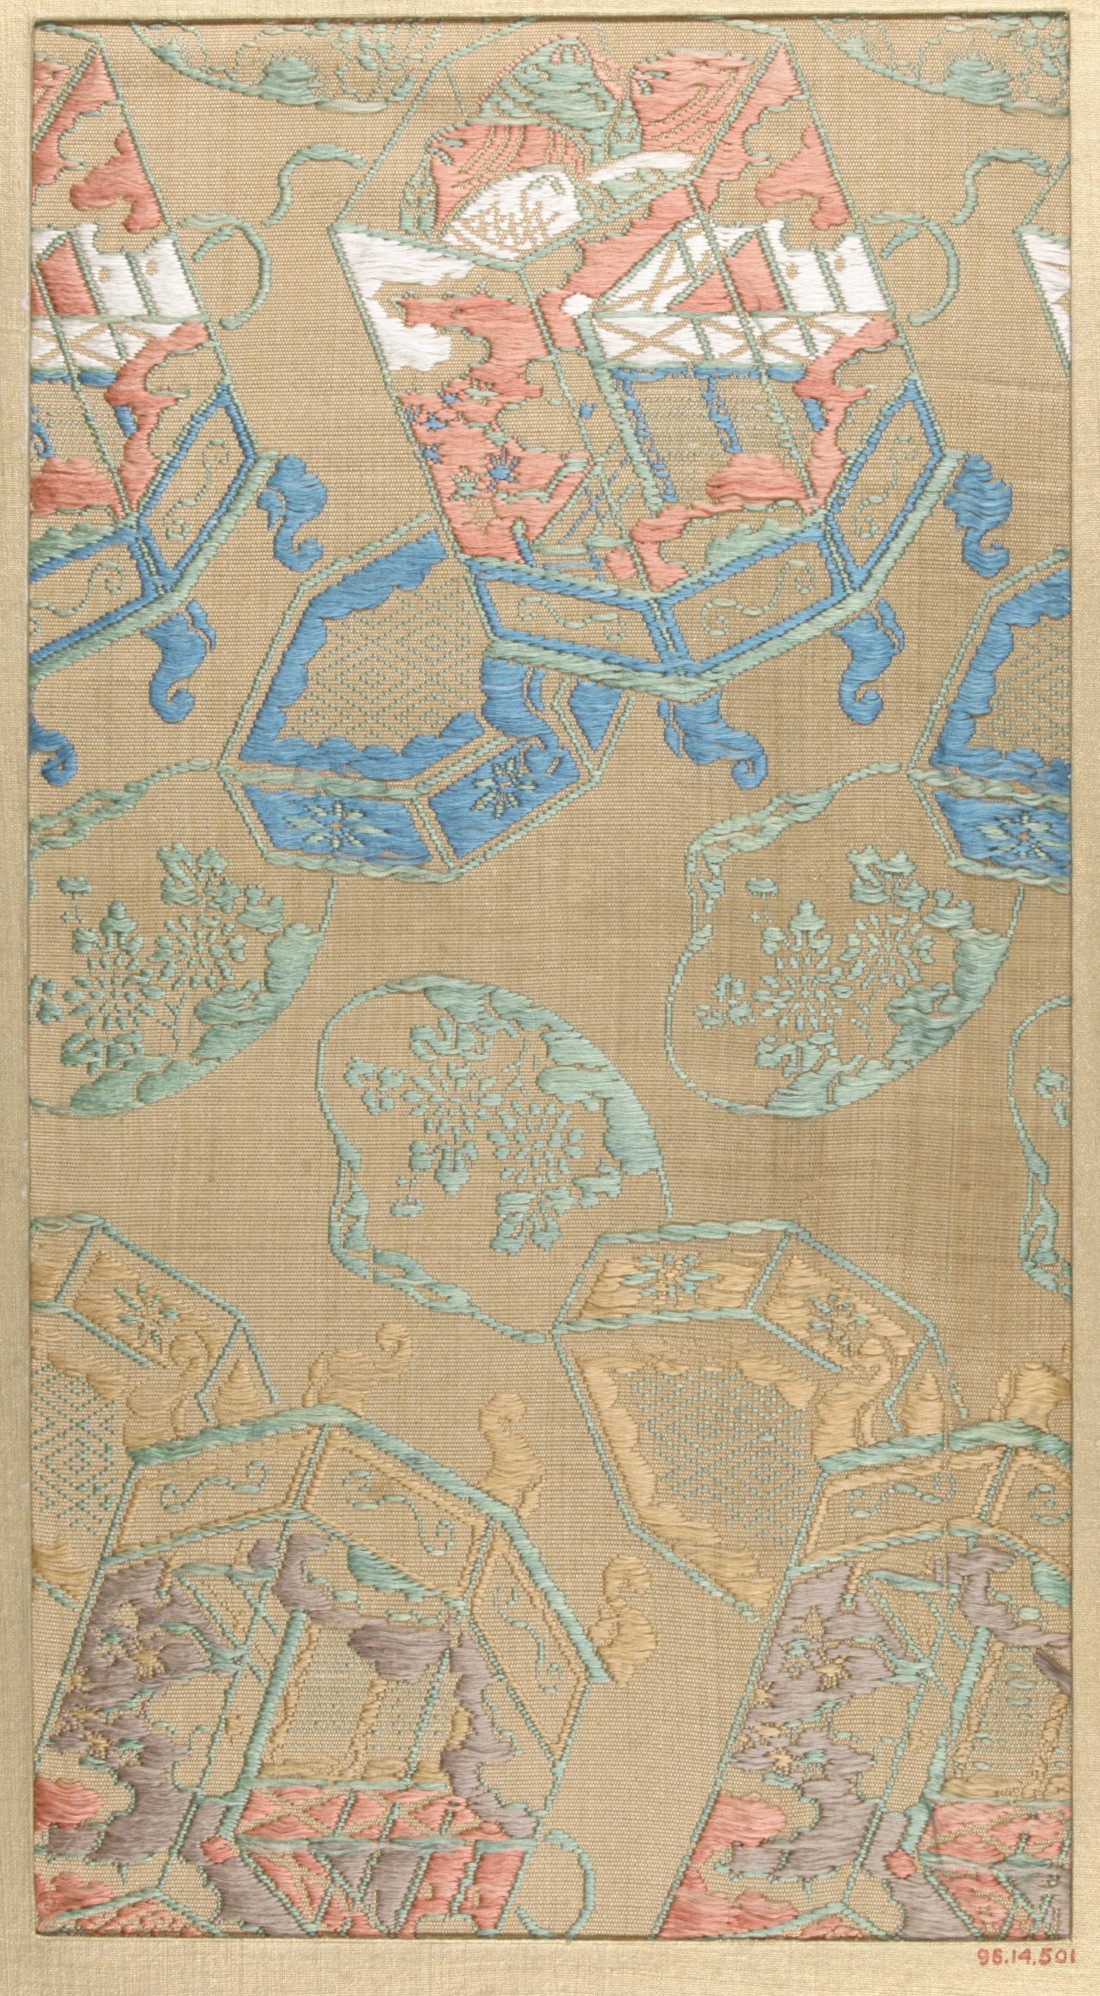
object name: piece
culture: japanese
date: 1701-1900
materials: silk